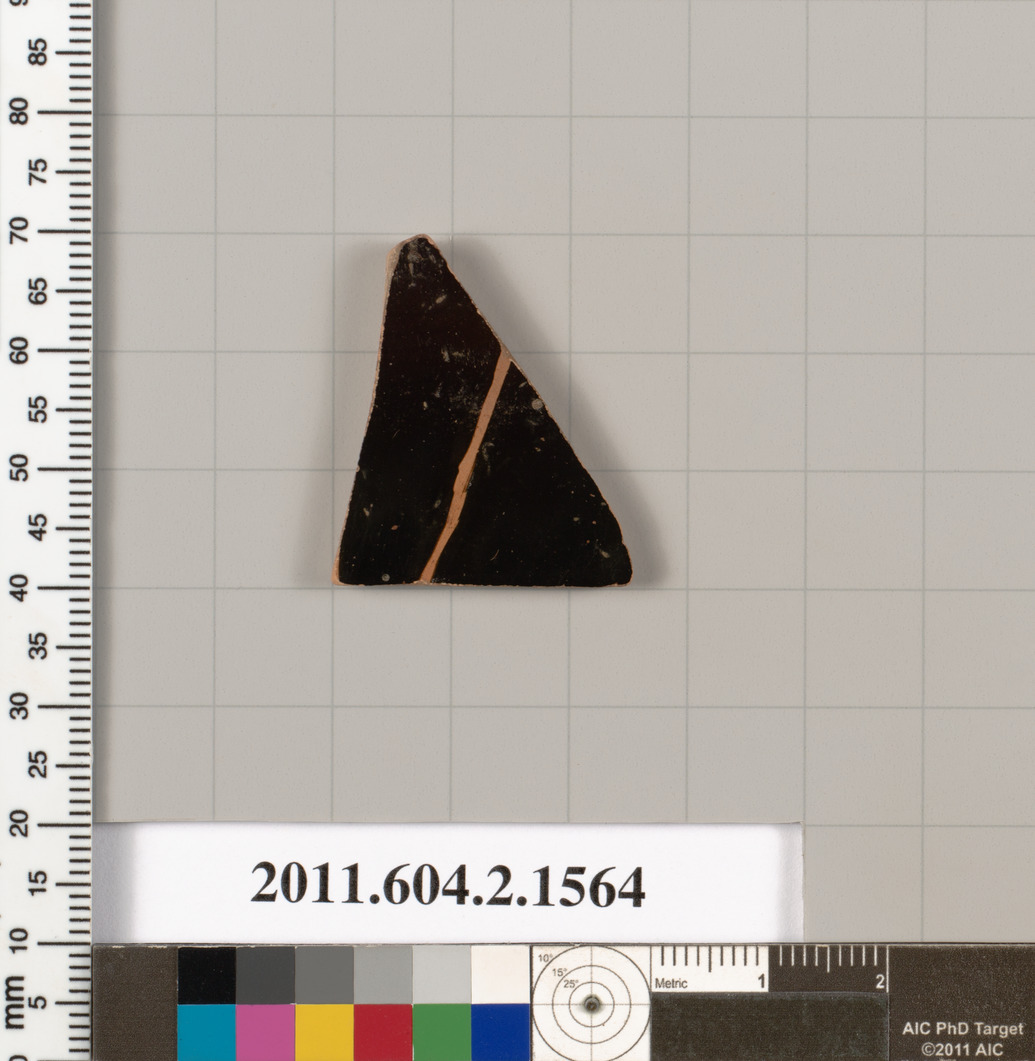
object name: skyphos fragment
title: Terracotta fragment of a skyphos (deep drinking cup)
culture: greek, attic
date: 475-425 BCE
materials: terracotta